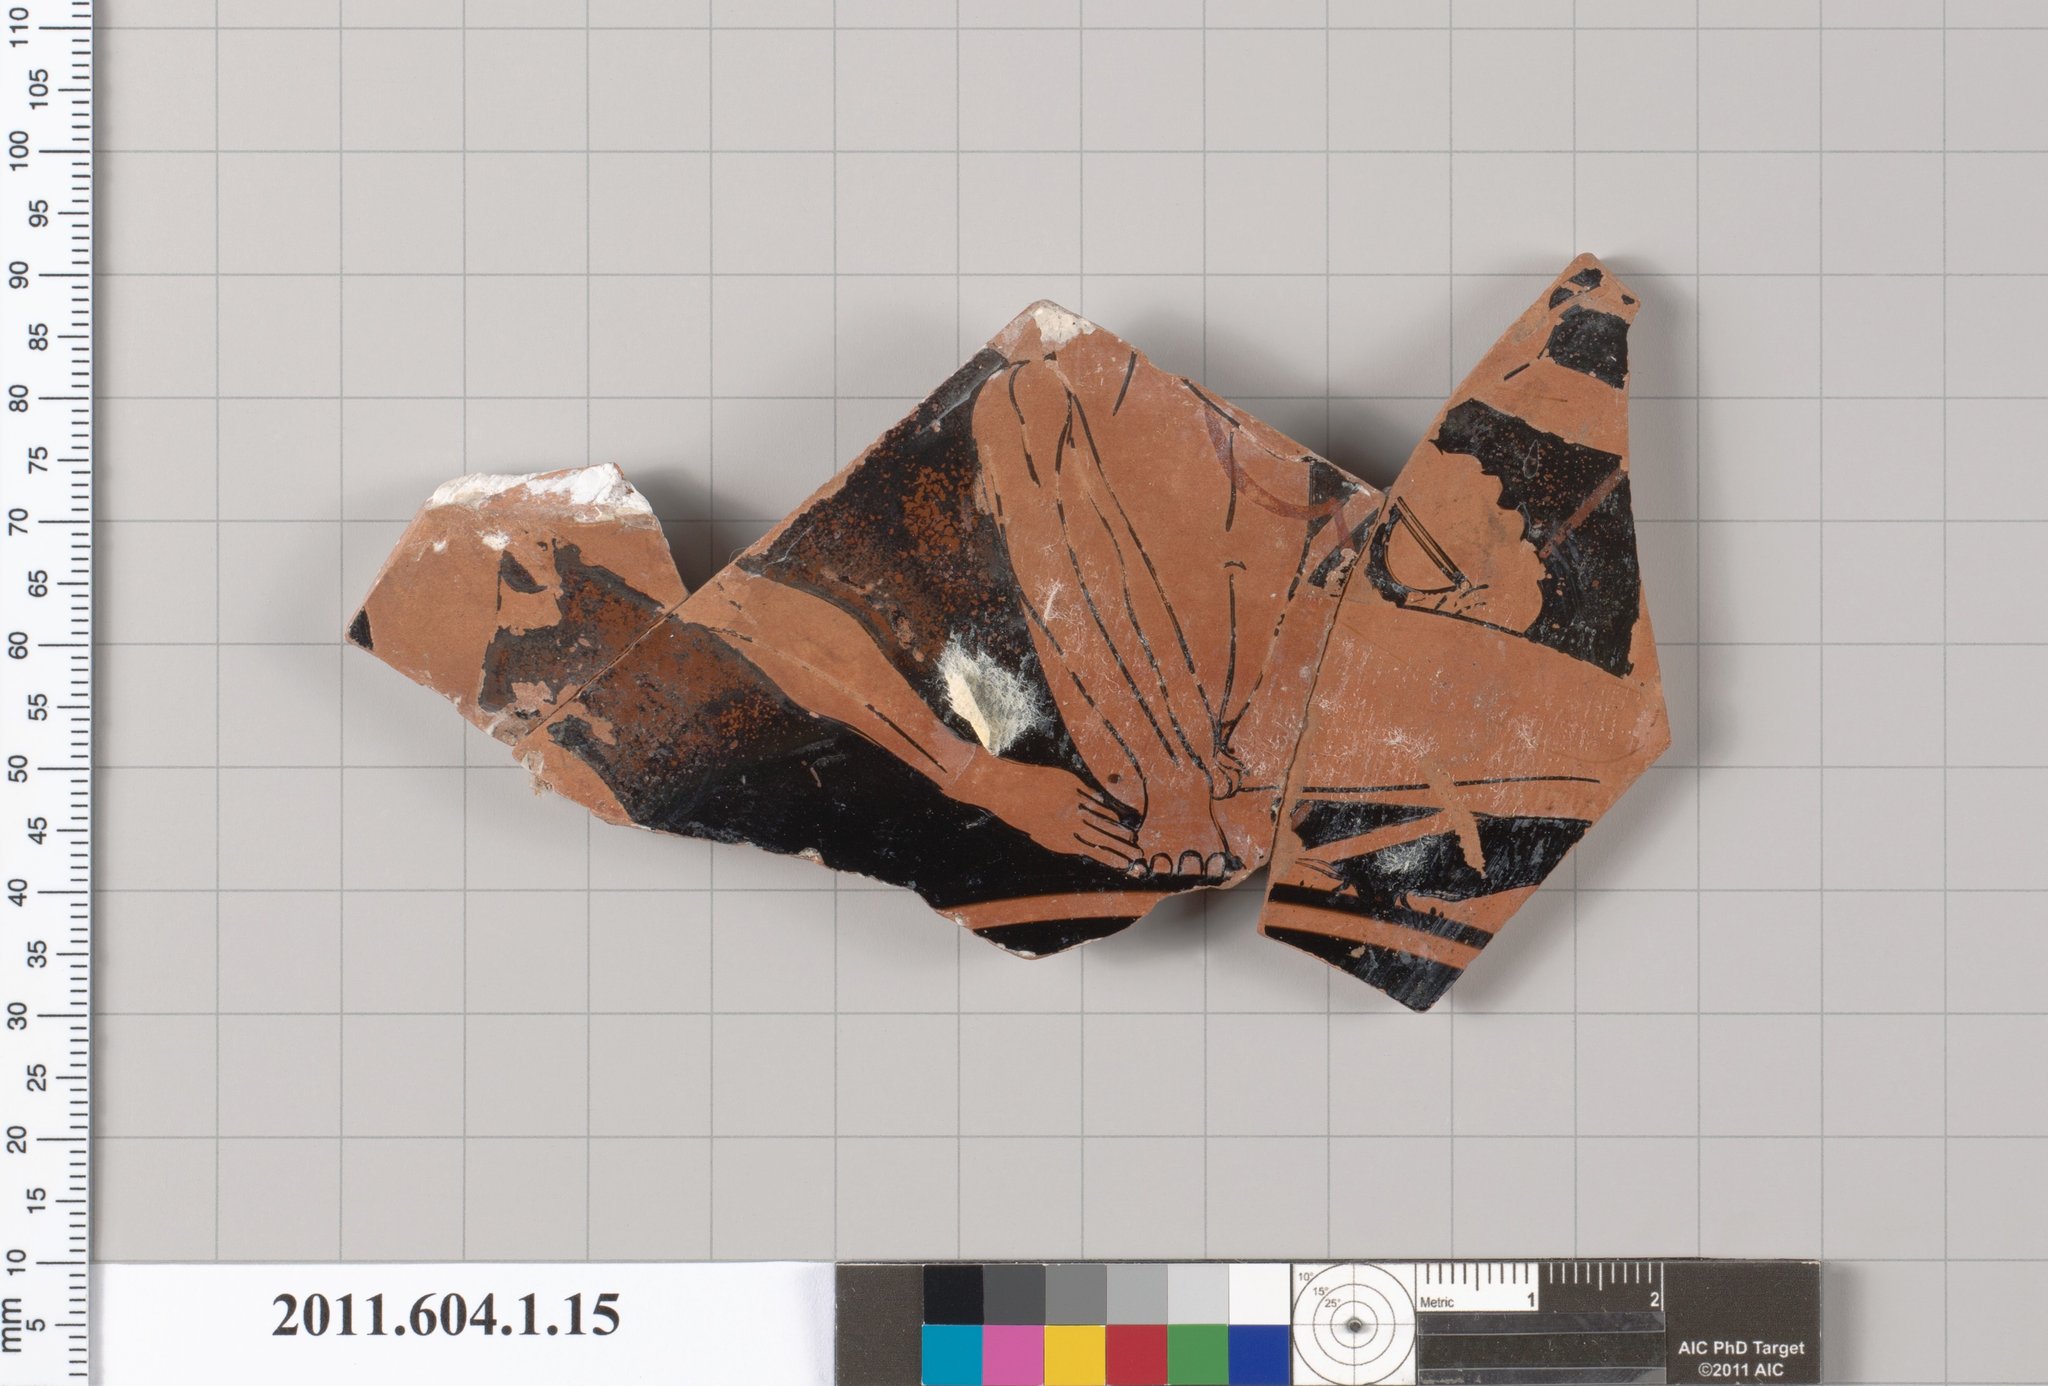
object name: kylix fragment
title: Terracotta fragment of a kylix (drinking cup)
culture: greek, attic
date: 475-451 BCE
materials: terracotta